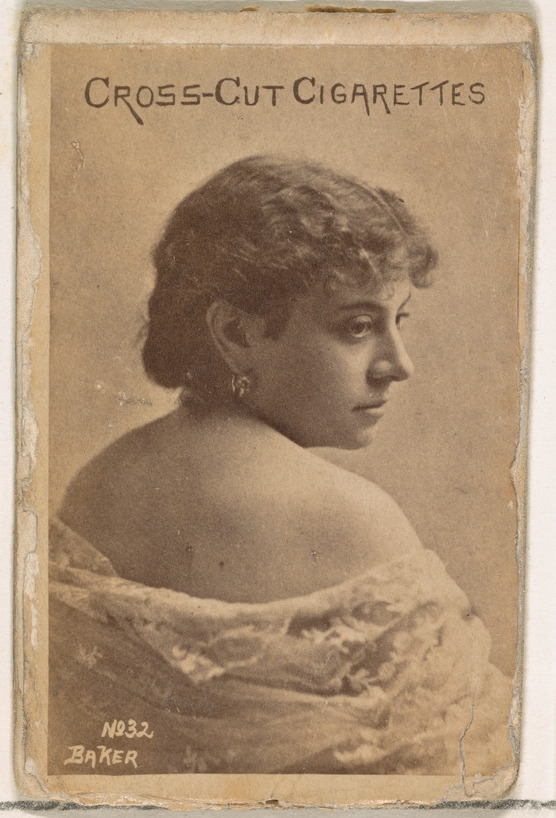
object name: print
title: Card Number 32, Baker, from the Actors and Actresses series (N145-1) issued by Duke Sons & Co. to promote Cross Cut Cigarettes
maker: w. duke, sons & co.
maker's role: publisher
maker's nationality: american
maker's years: 1870-1920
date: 1880-1889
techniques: albumen silver print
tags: profiles,women,actresses